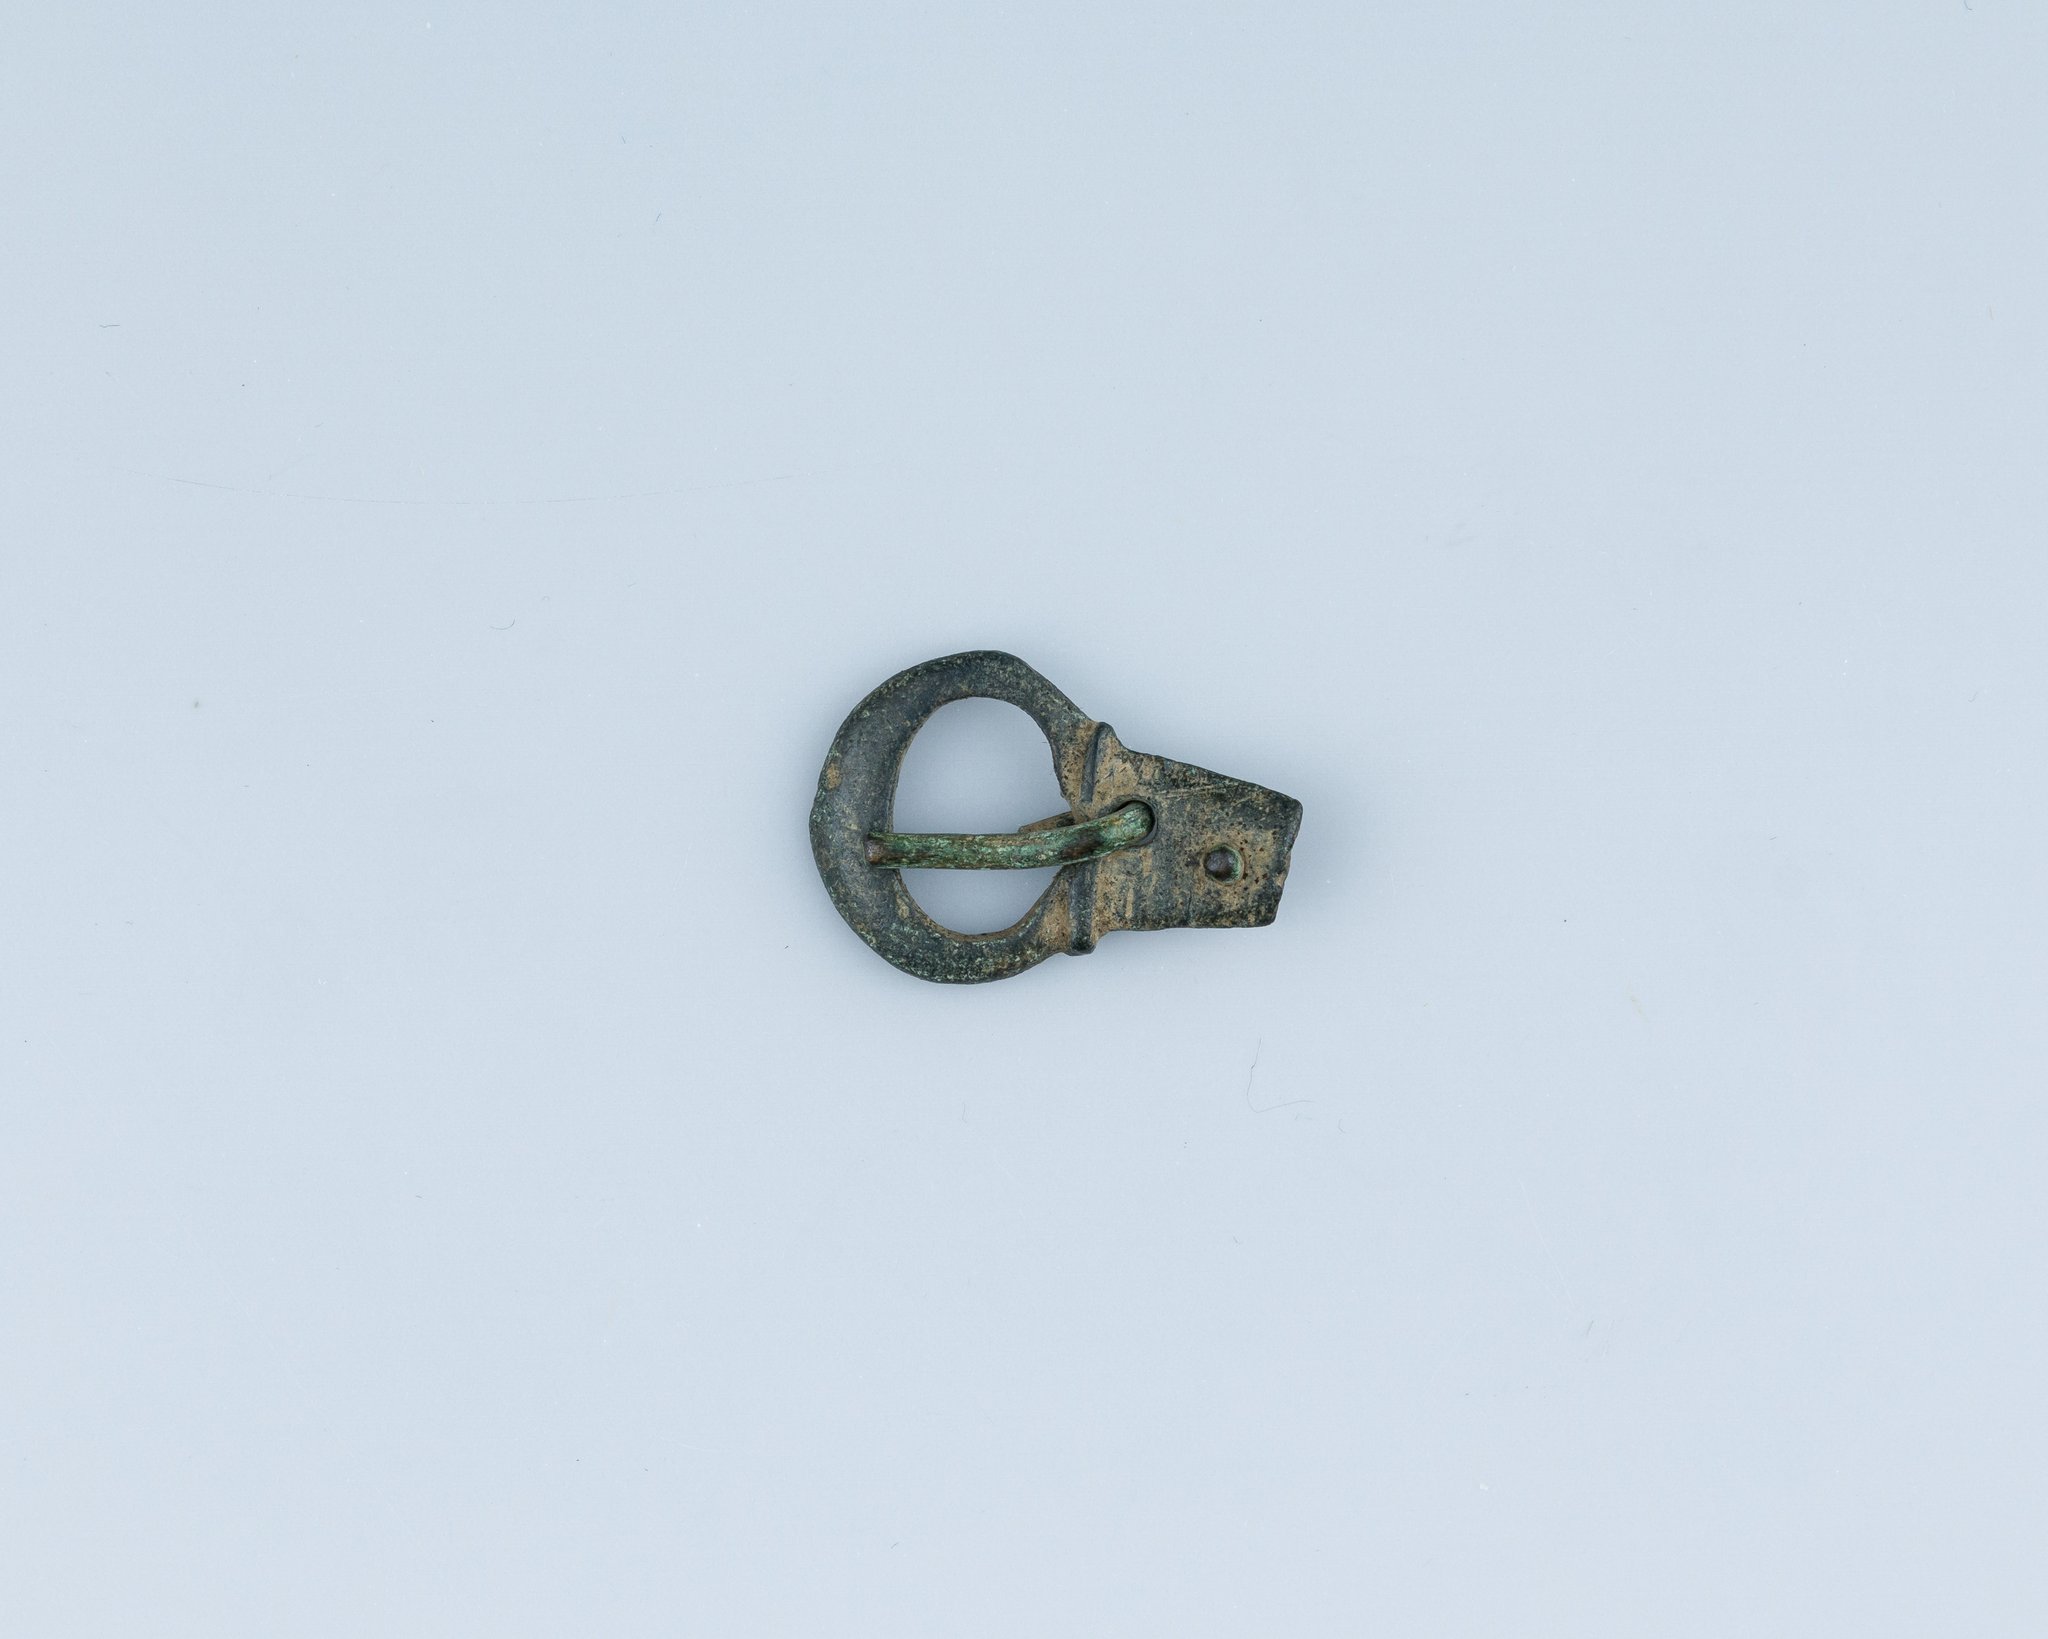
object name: buckle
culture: european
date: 1401-1600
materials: bronze